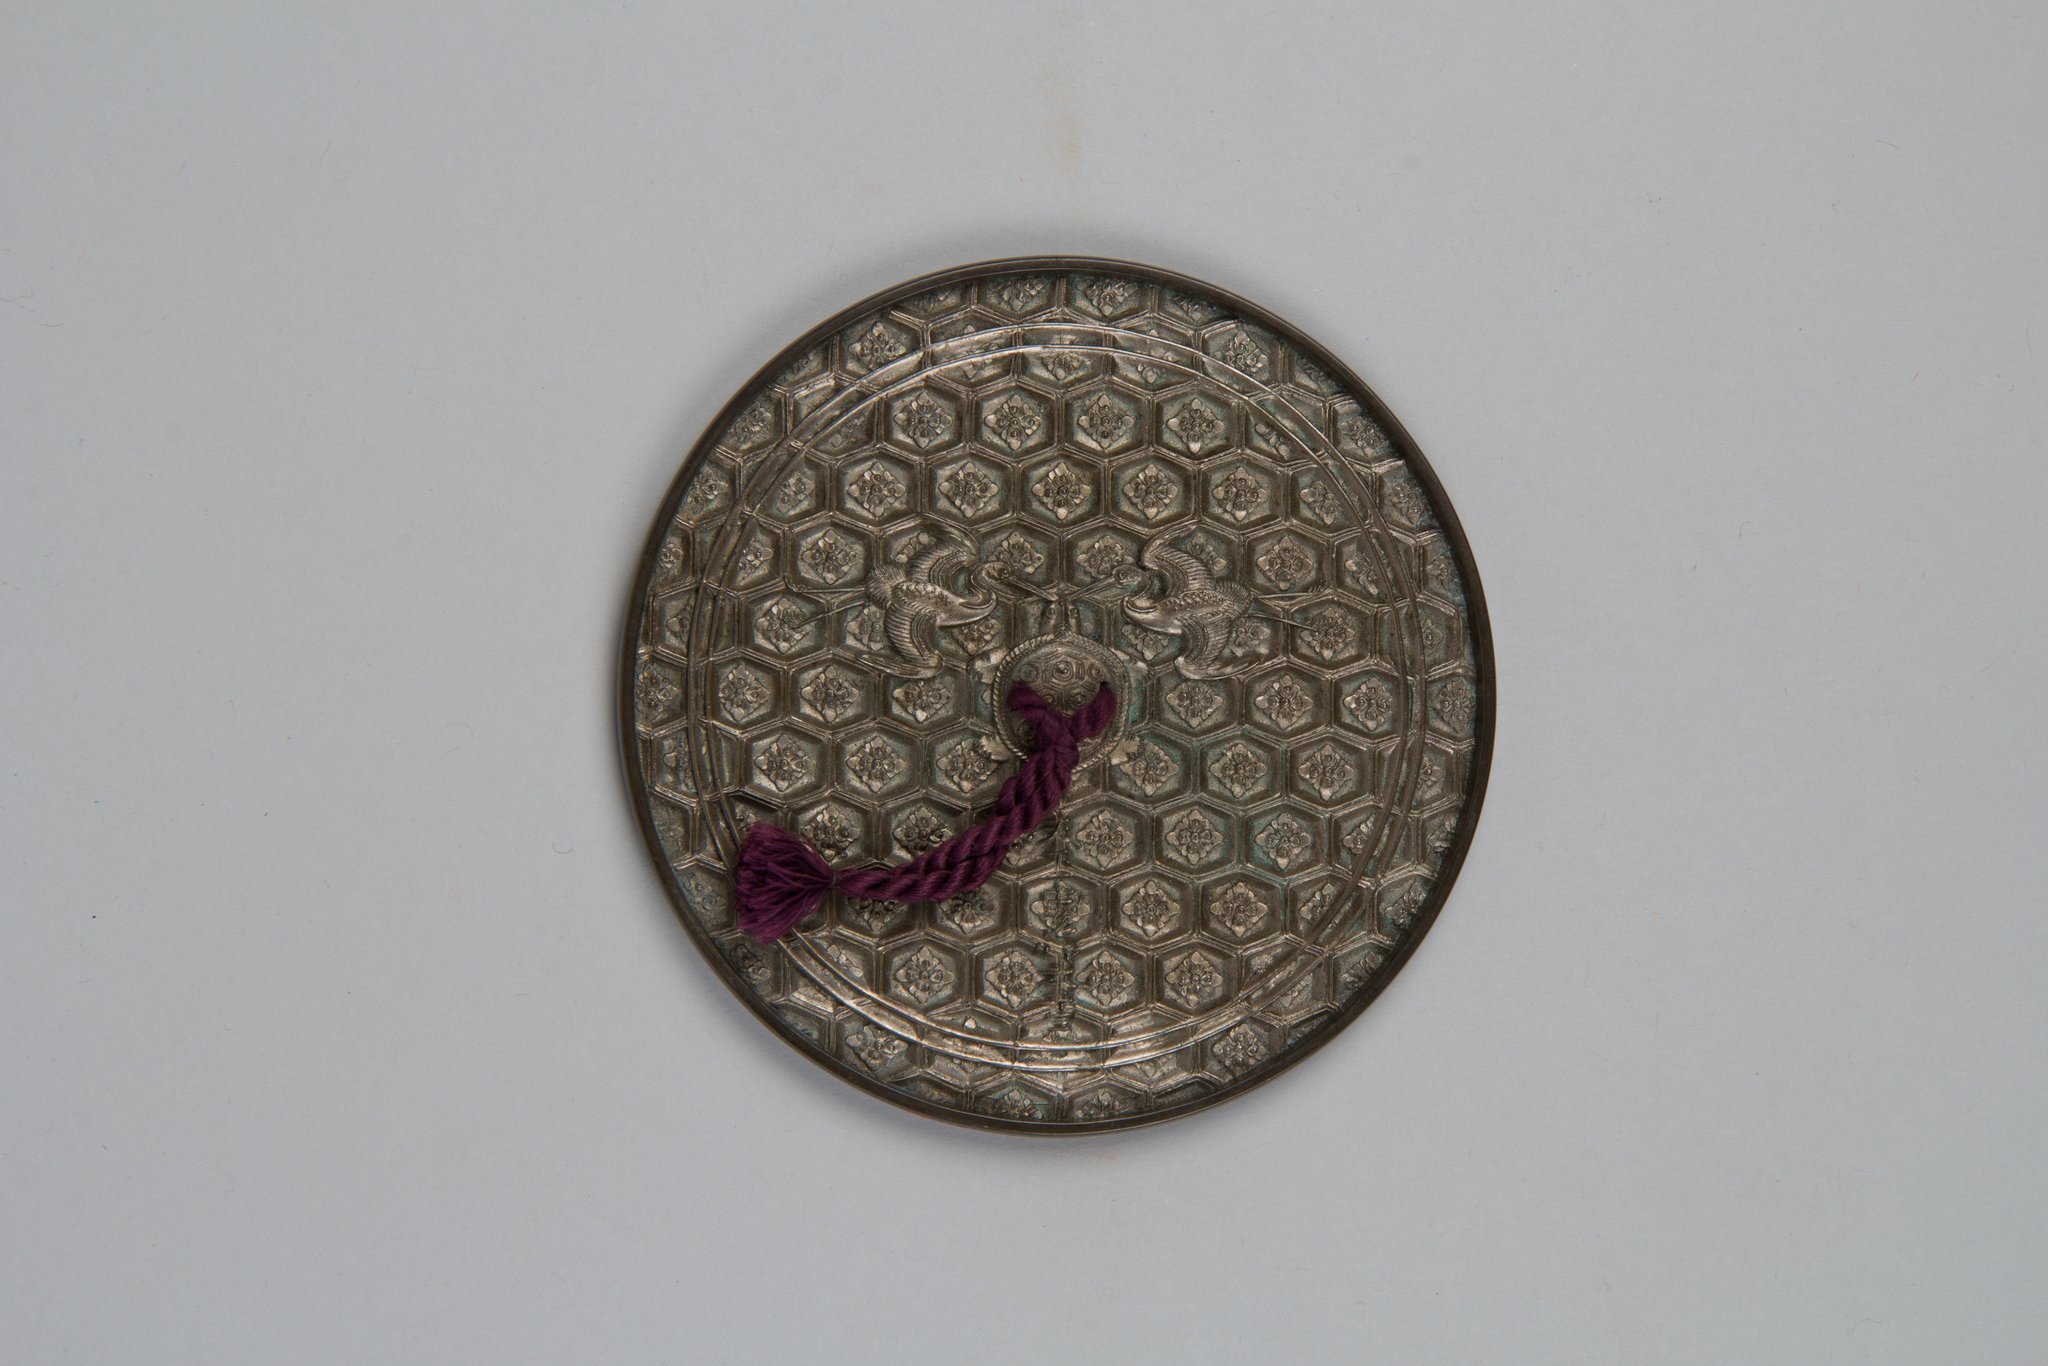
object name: mirror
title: Mirror with Decoration of Paradise of the Immortals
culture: japanese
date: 1615-1868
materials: bronze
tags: cranes